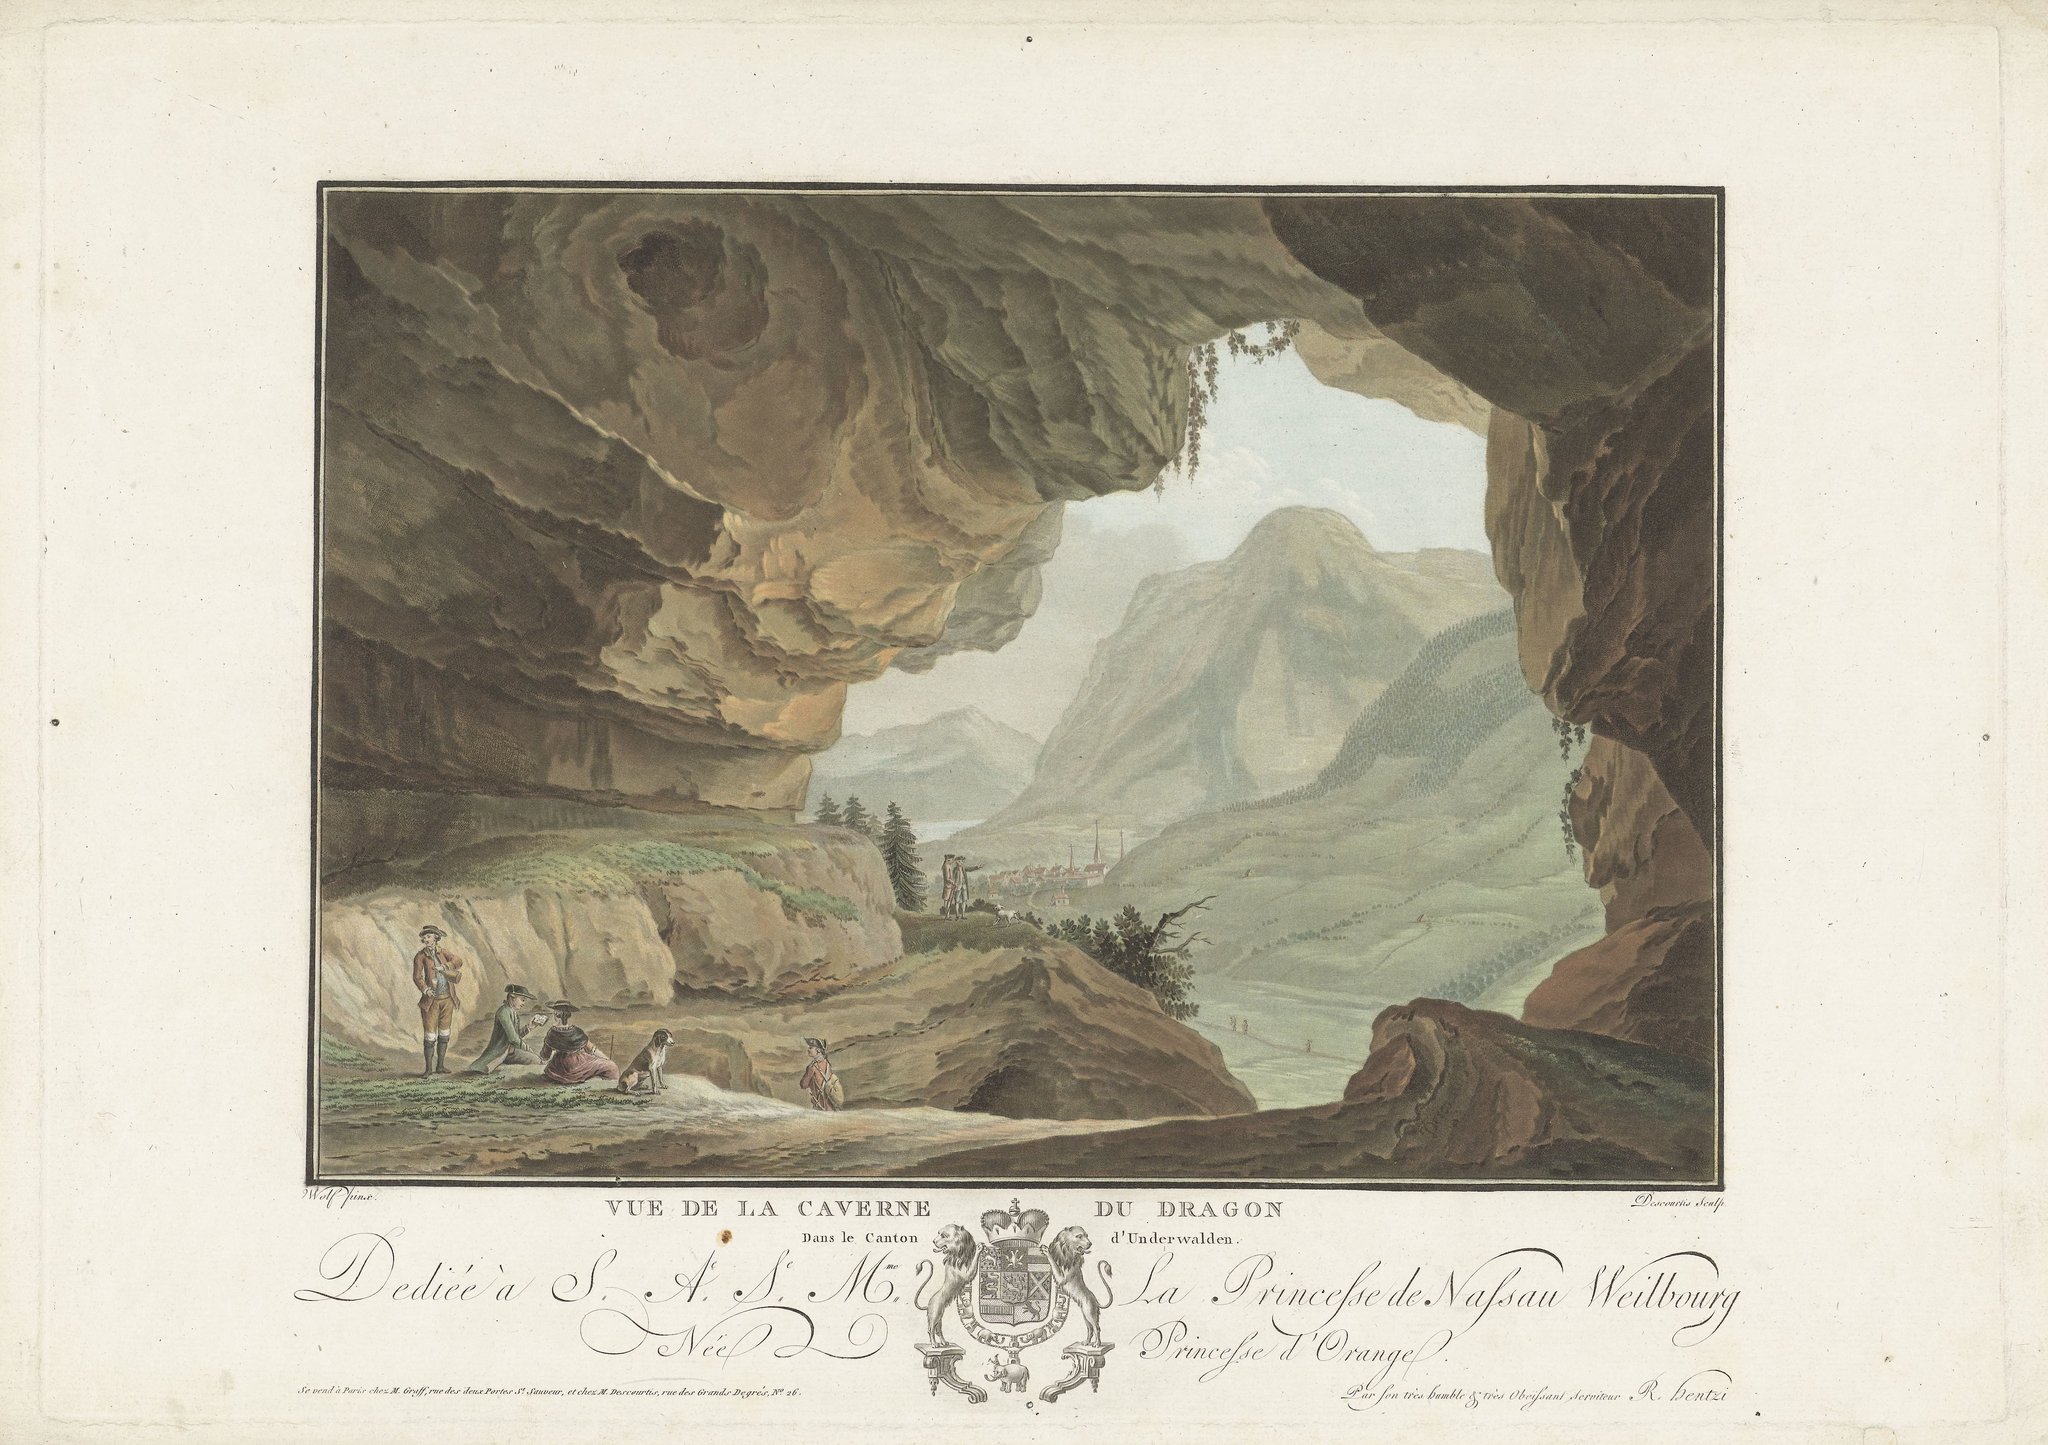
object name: print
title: Vues remarquables des montagnes de la Suisse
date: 1763-1820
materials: paper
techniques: etching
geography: paris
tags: cave, grotto, outing, pleasure trip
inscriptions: collector's mark: Lugt 2760, collector's mark: Lugt 2228, dedication: ‘Dediée a S. A. J.M. La Princese de Nassau Weilburg Née Princesse d' Orange/par sons tres humble et tres obéissant serviteur R. Bentzi’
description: Gezicht vanuit een grot in Unterwalden in Zwitserland. Drie heren, een dame en een hond rusten uit in de grot. Op het tweede plan twee heren die naar het dal wijzen. Onder de voorstelling tekst en een wapenschild van Carolina van Nassau-Weilburg.